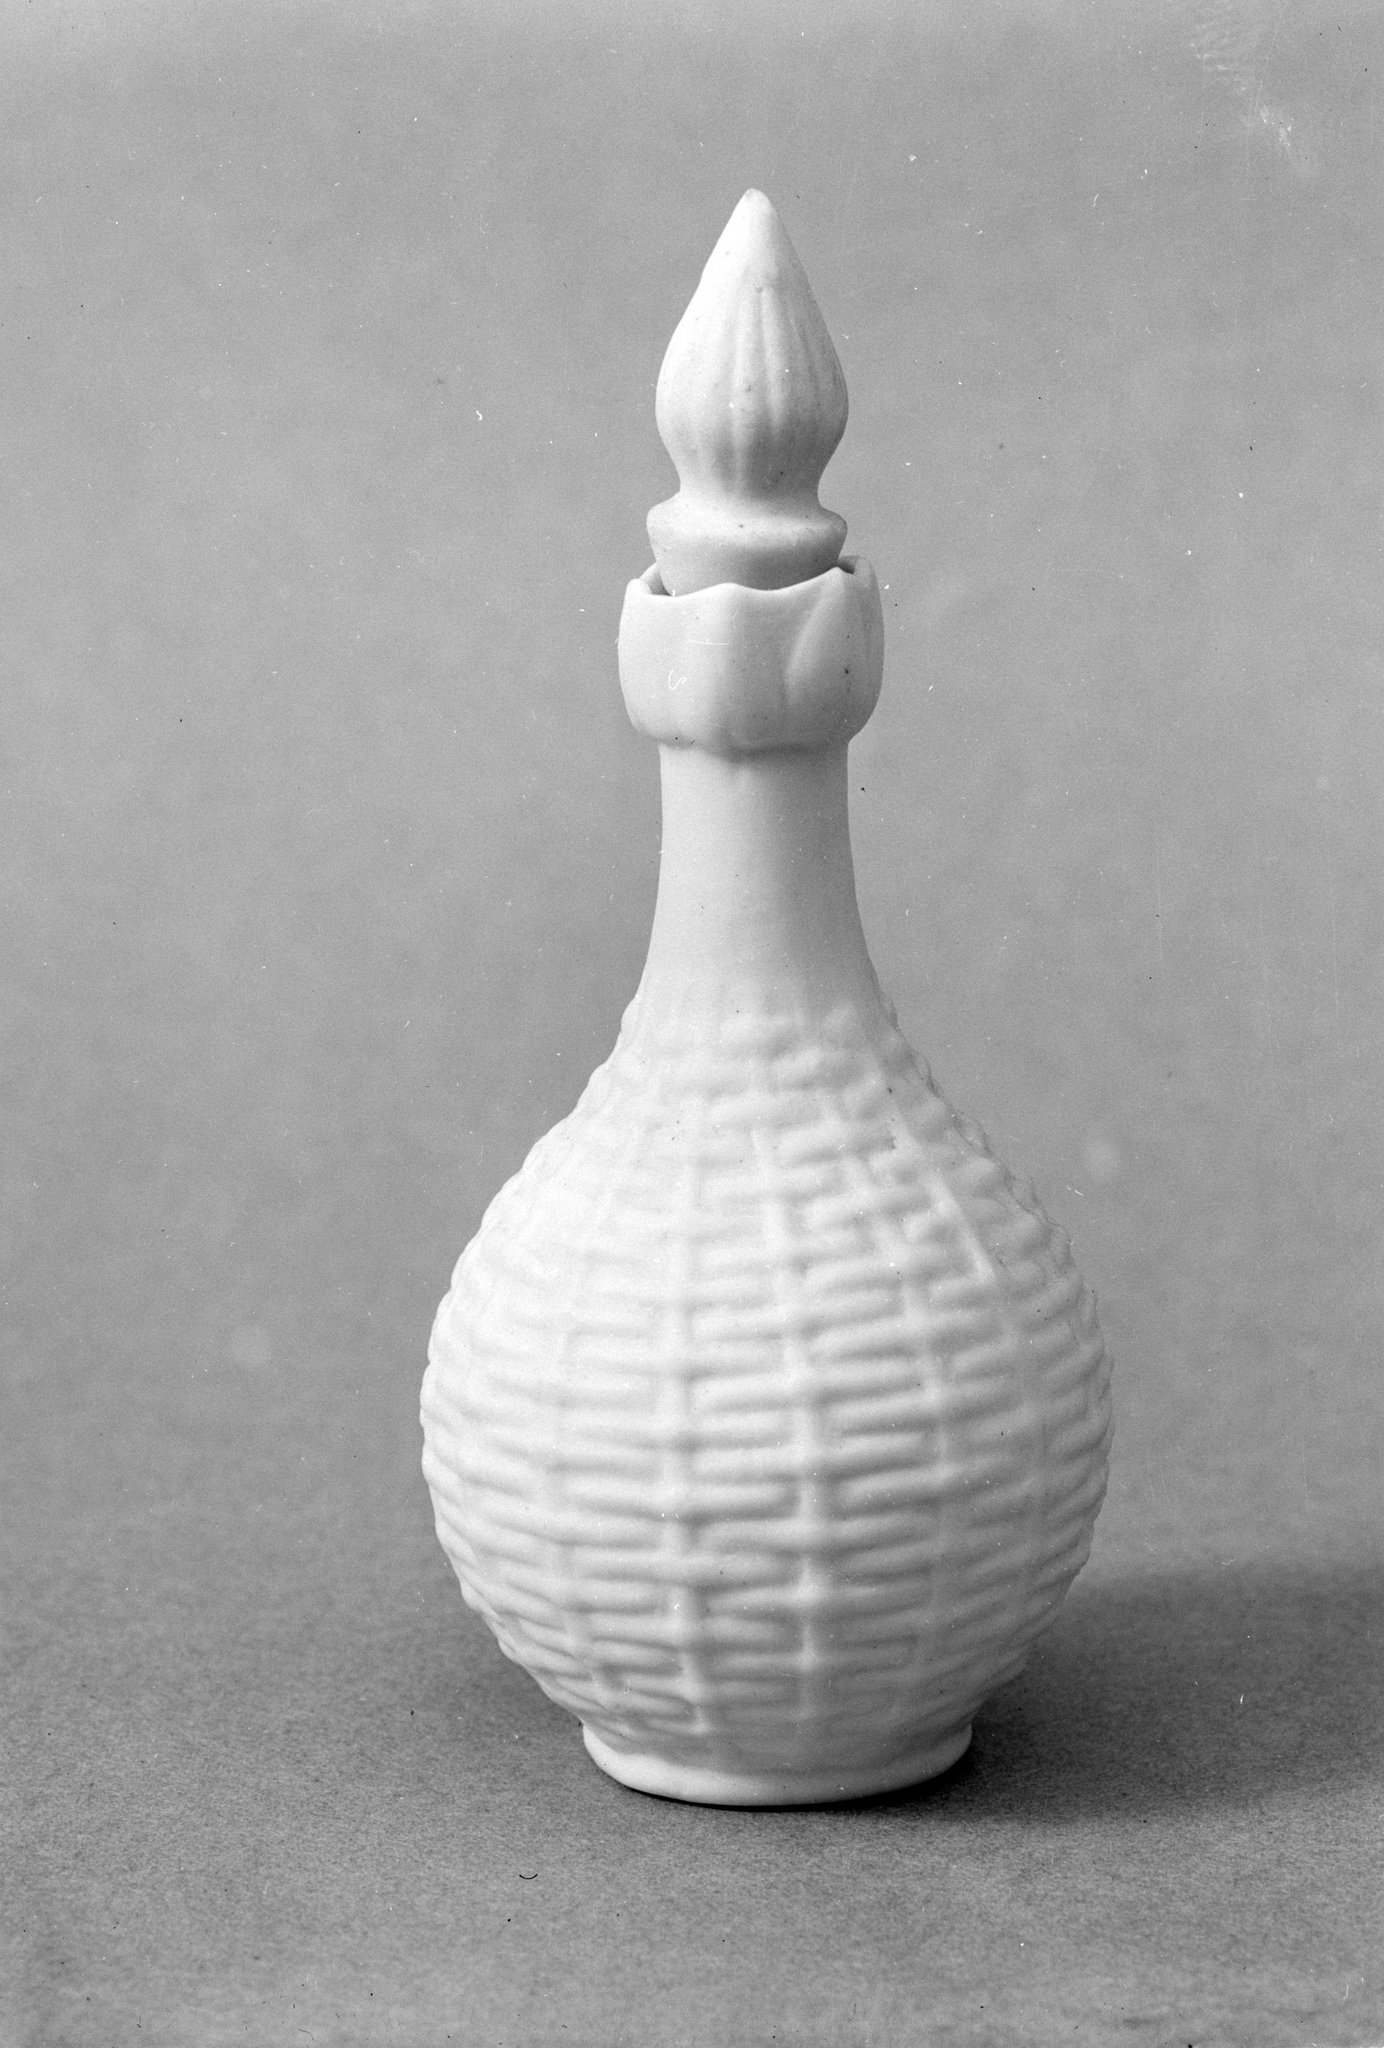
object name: perfume bottle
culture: american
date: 1830-1870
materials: porcelain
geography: united states